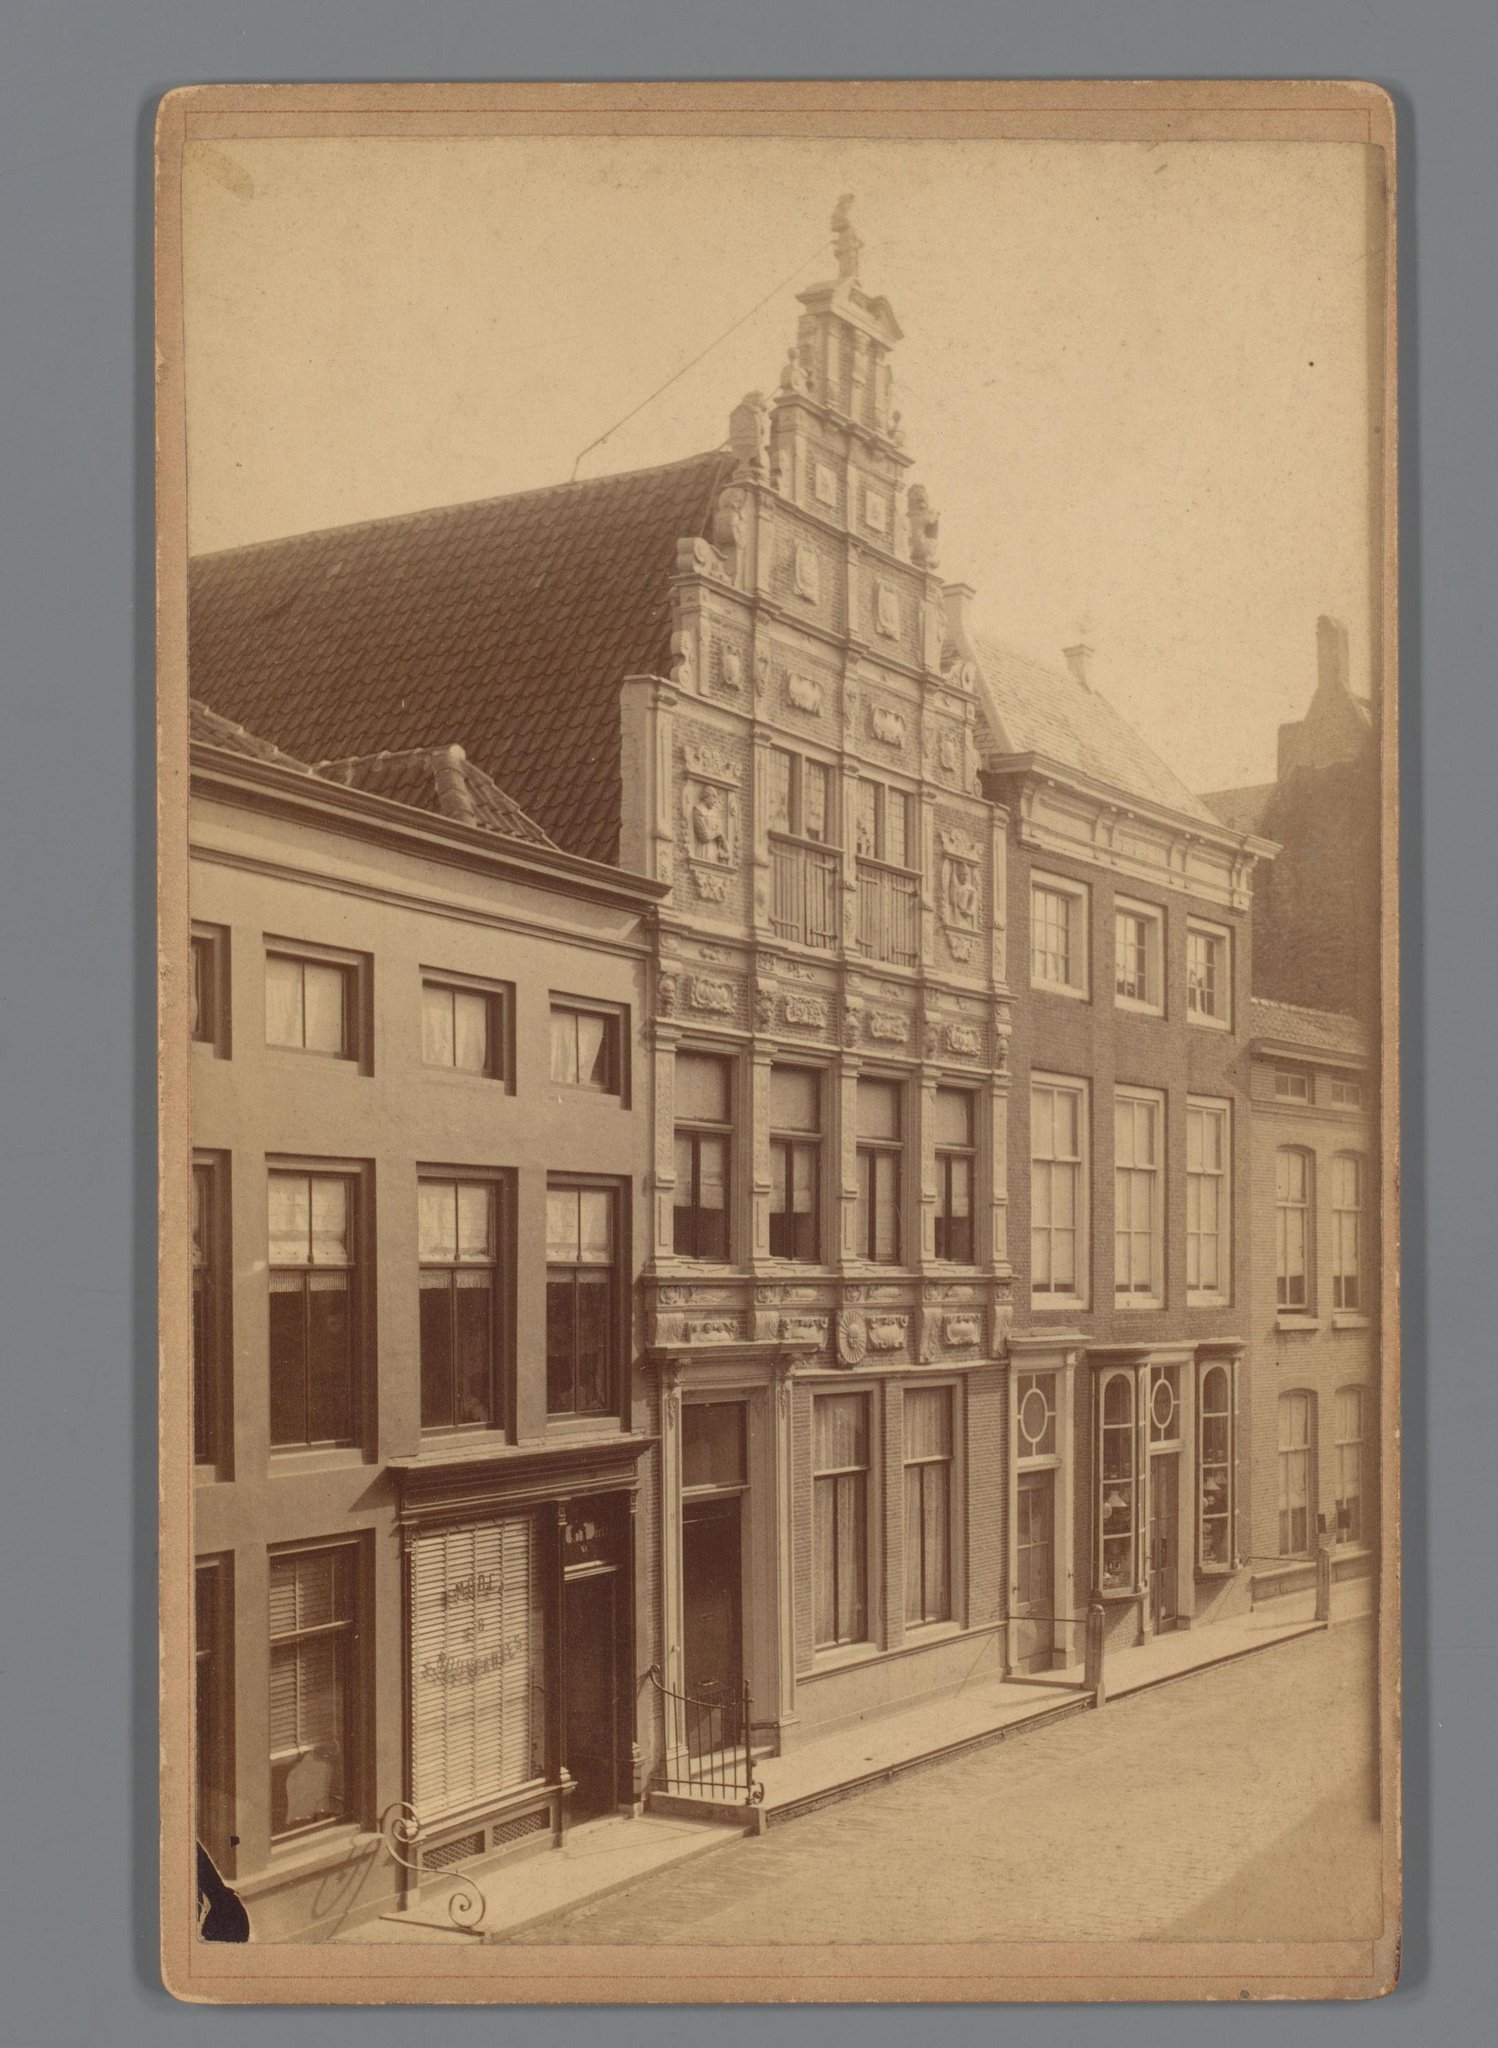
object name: cabinet photograph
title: Straatgezicht met houten gevel in de Lange Delft te Middelburg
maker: Anonymous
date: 1870-1900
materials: cardboard, photographic support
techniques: albumen print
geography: middelburg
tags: façade (of house or building), middelburg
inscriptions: annotation: ‘Middelburg’